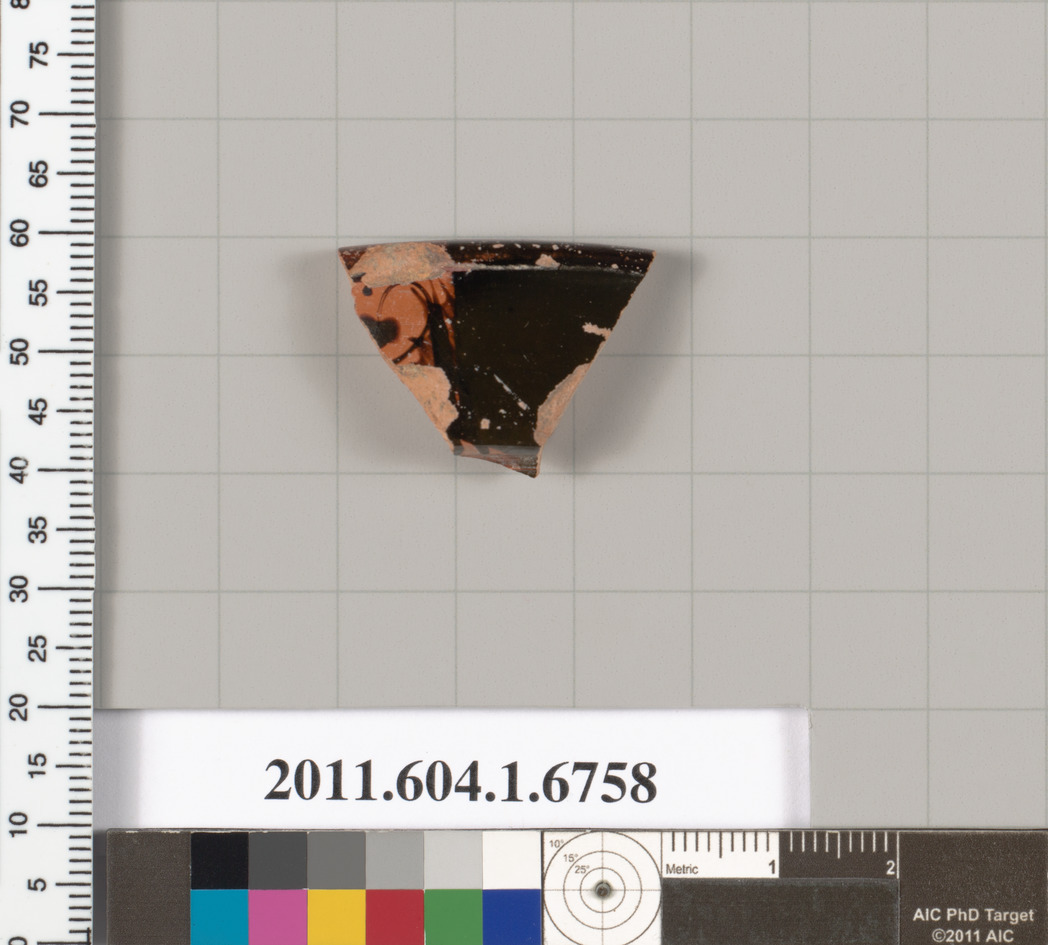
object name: kylix fragment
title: Terracotta rim fragment of a kylix (drinking cup)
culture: greek, attic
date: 490-470 BCE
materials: terracotta